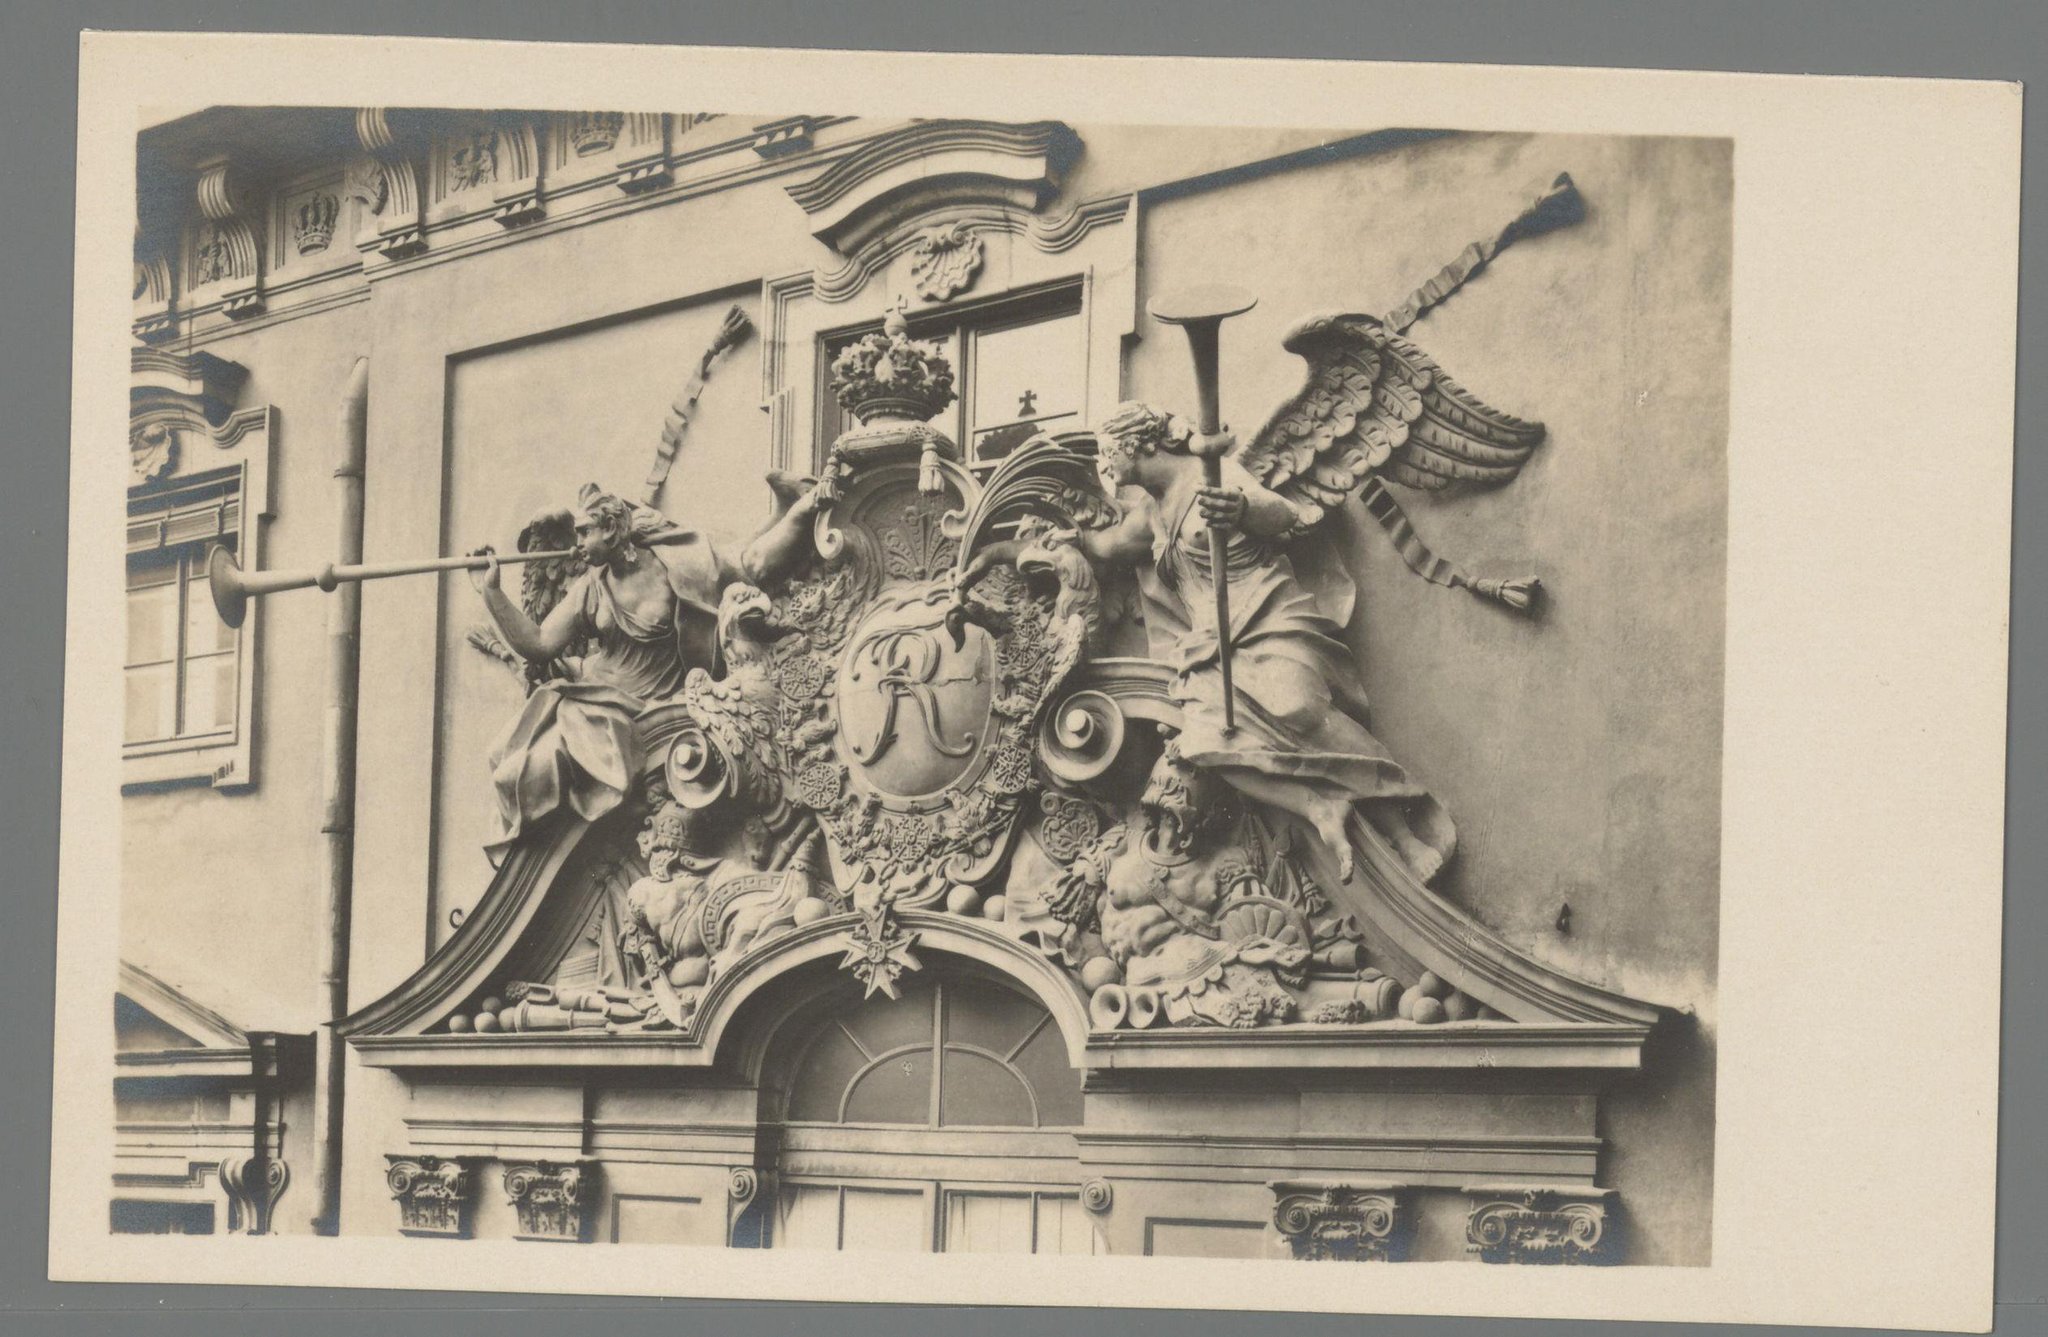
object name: photograph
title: Berlin, Schloss. Westlicher Schlosshof, Giebelbekrönung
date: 1900-1930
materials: photographic support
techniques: photography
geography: berlin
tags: castle, façade (of house or building)